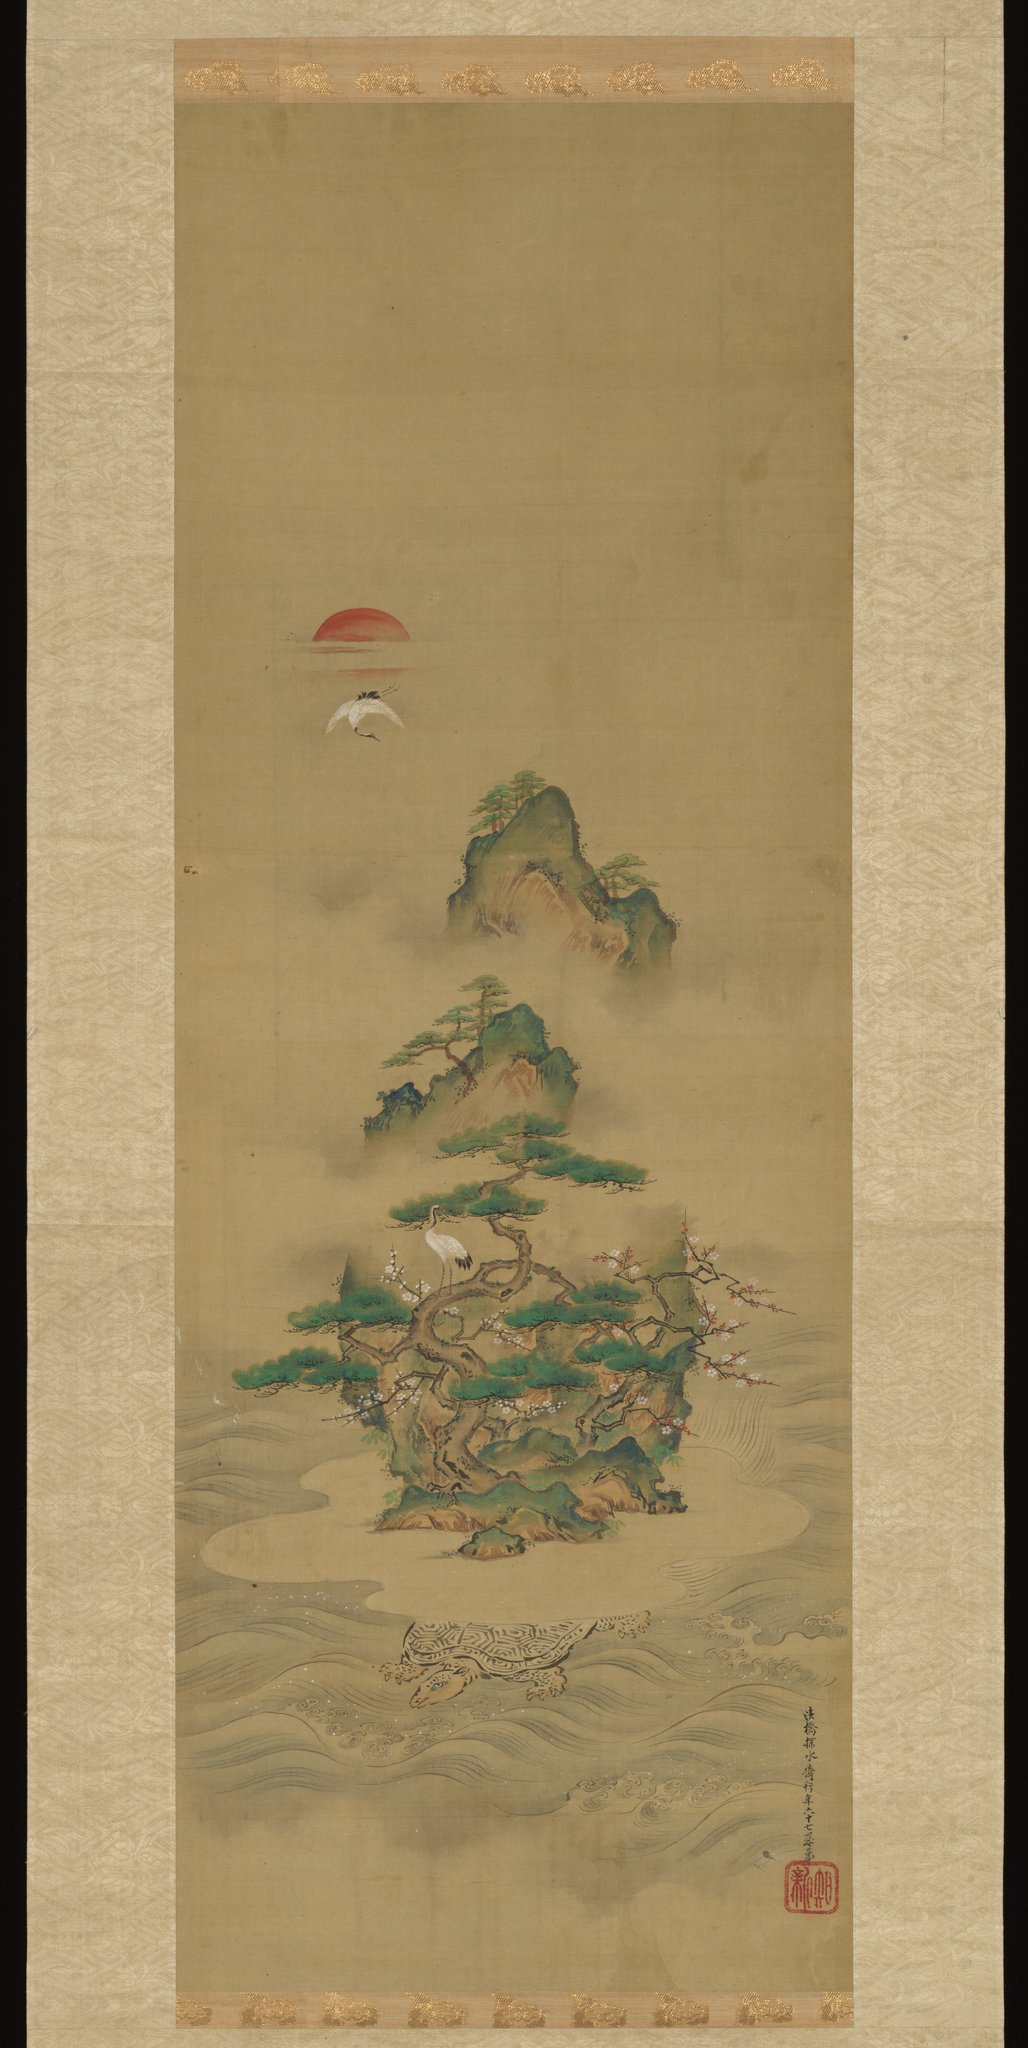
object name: hanging scroll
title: Mount Penglai with Eight Views of Xiao and Xiang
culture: japanese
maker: kano tansui moritsune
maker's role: artist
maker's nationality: japanese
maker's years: 1800-1899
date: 1801-1900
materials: ink, silk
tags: birds,turtles,mountains,landscapes